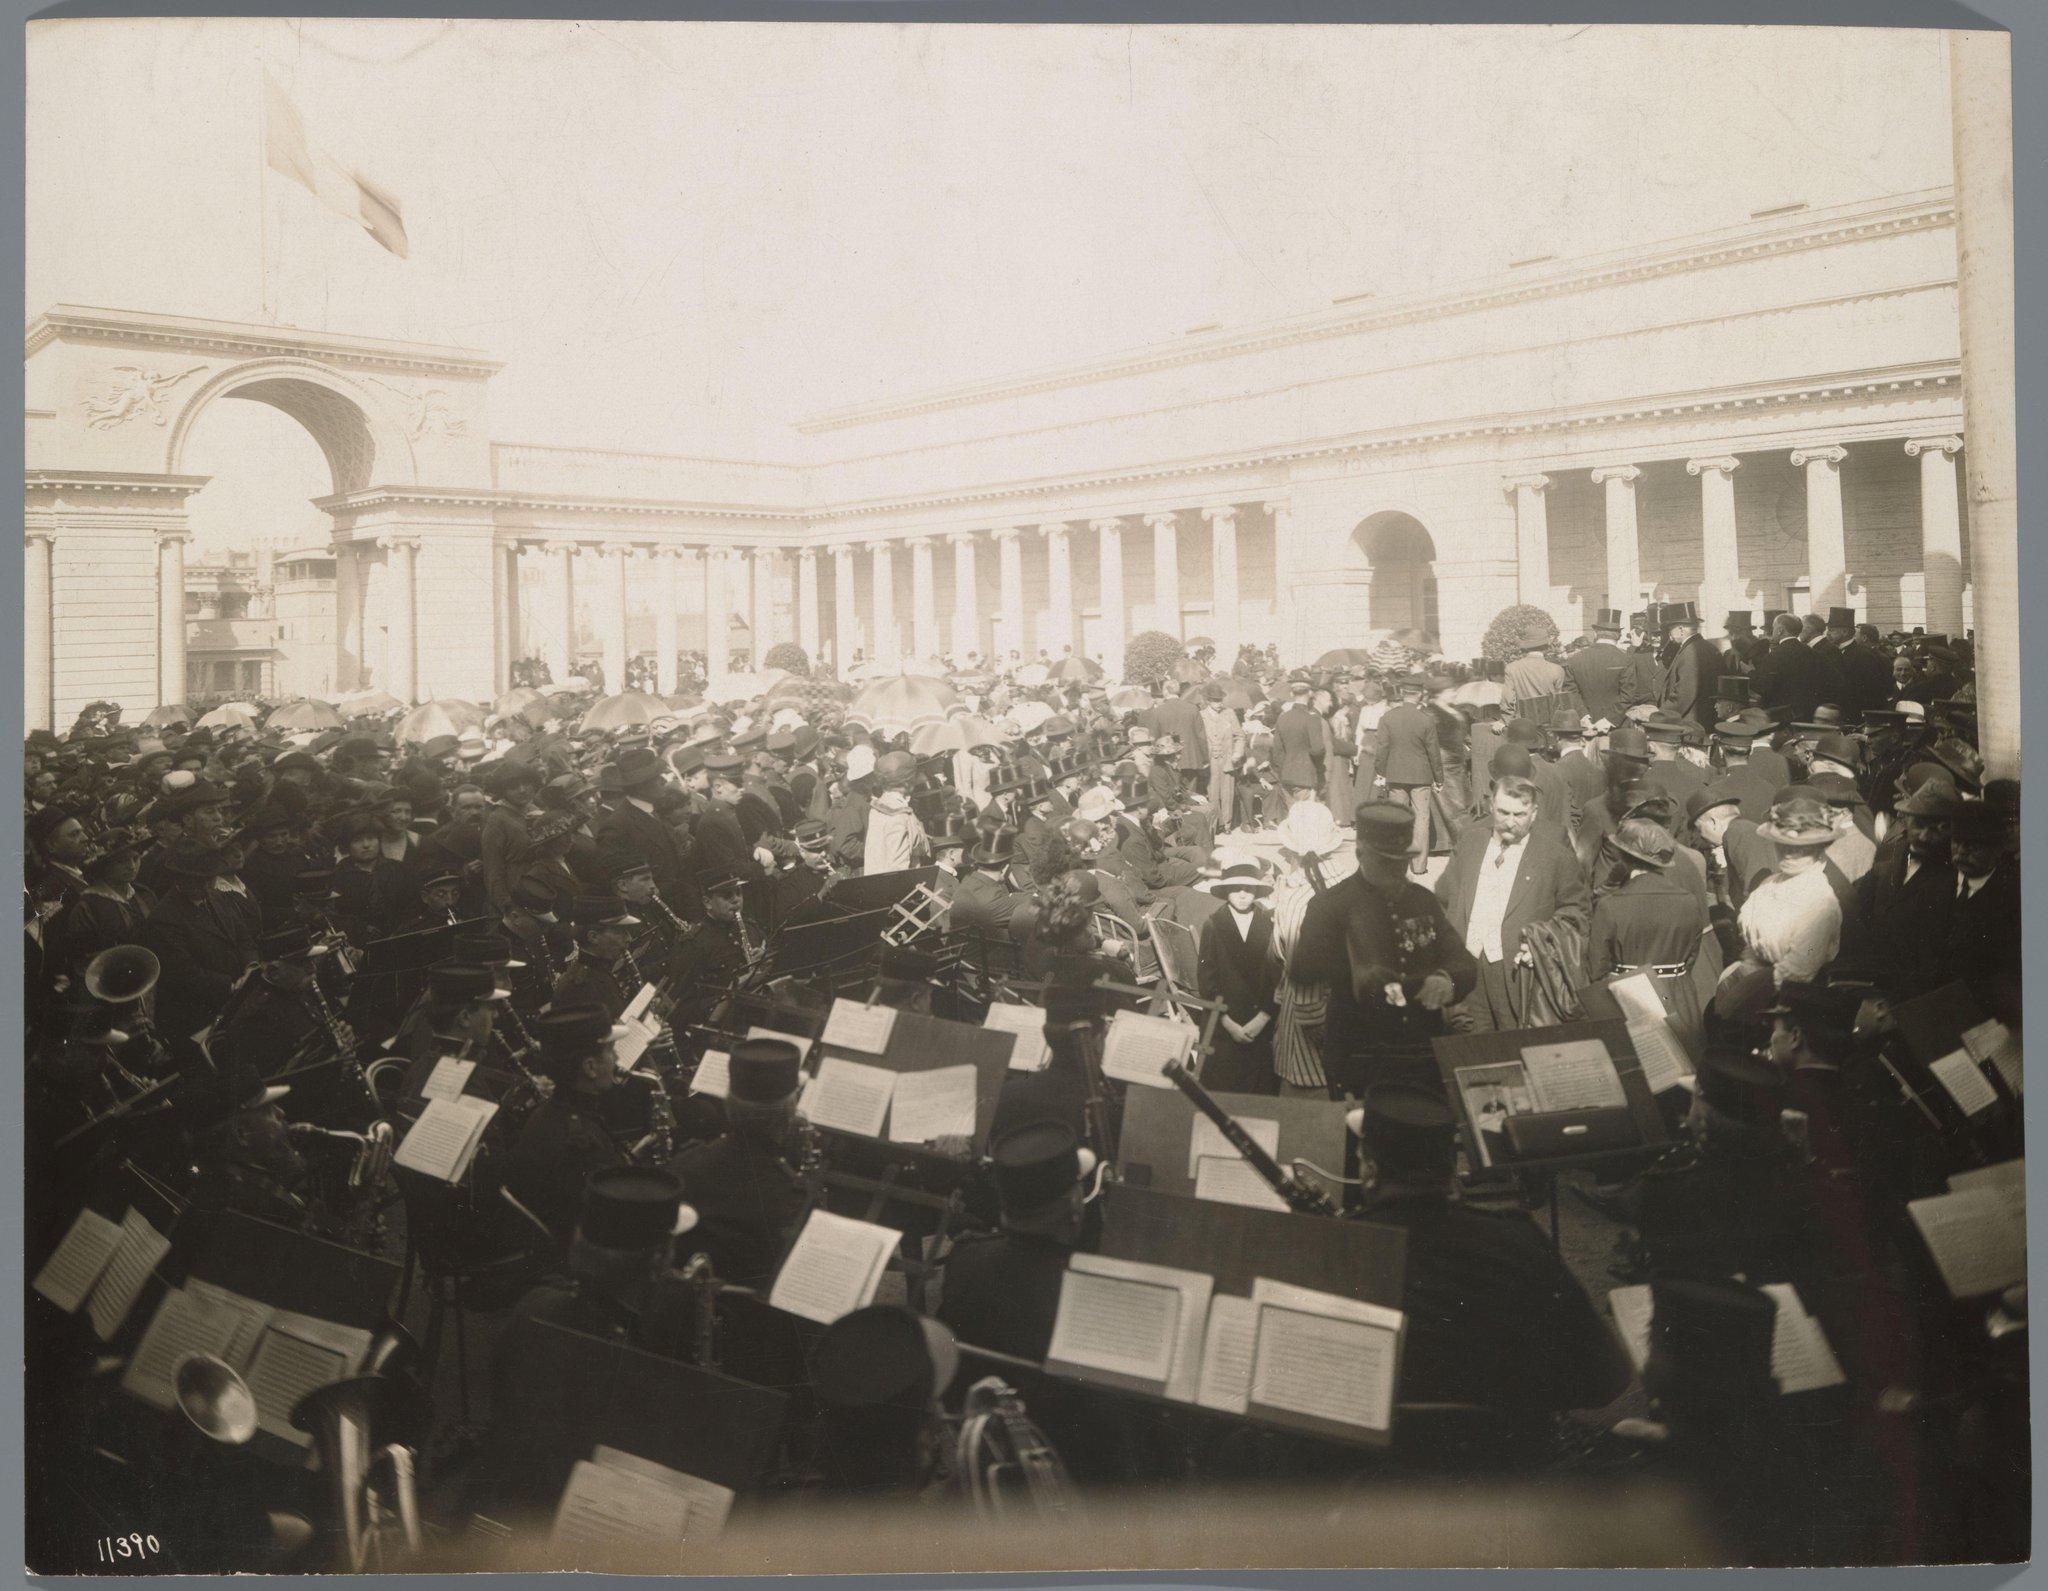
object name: photograph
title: Publiek voor paviljoen (San Francisco)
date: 1860-1915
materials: paper, photographic support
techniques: gelatin silver print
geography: san francisco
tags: san francisco